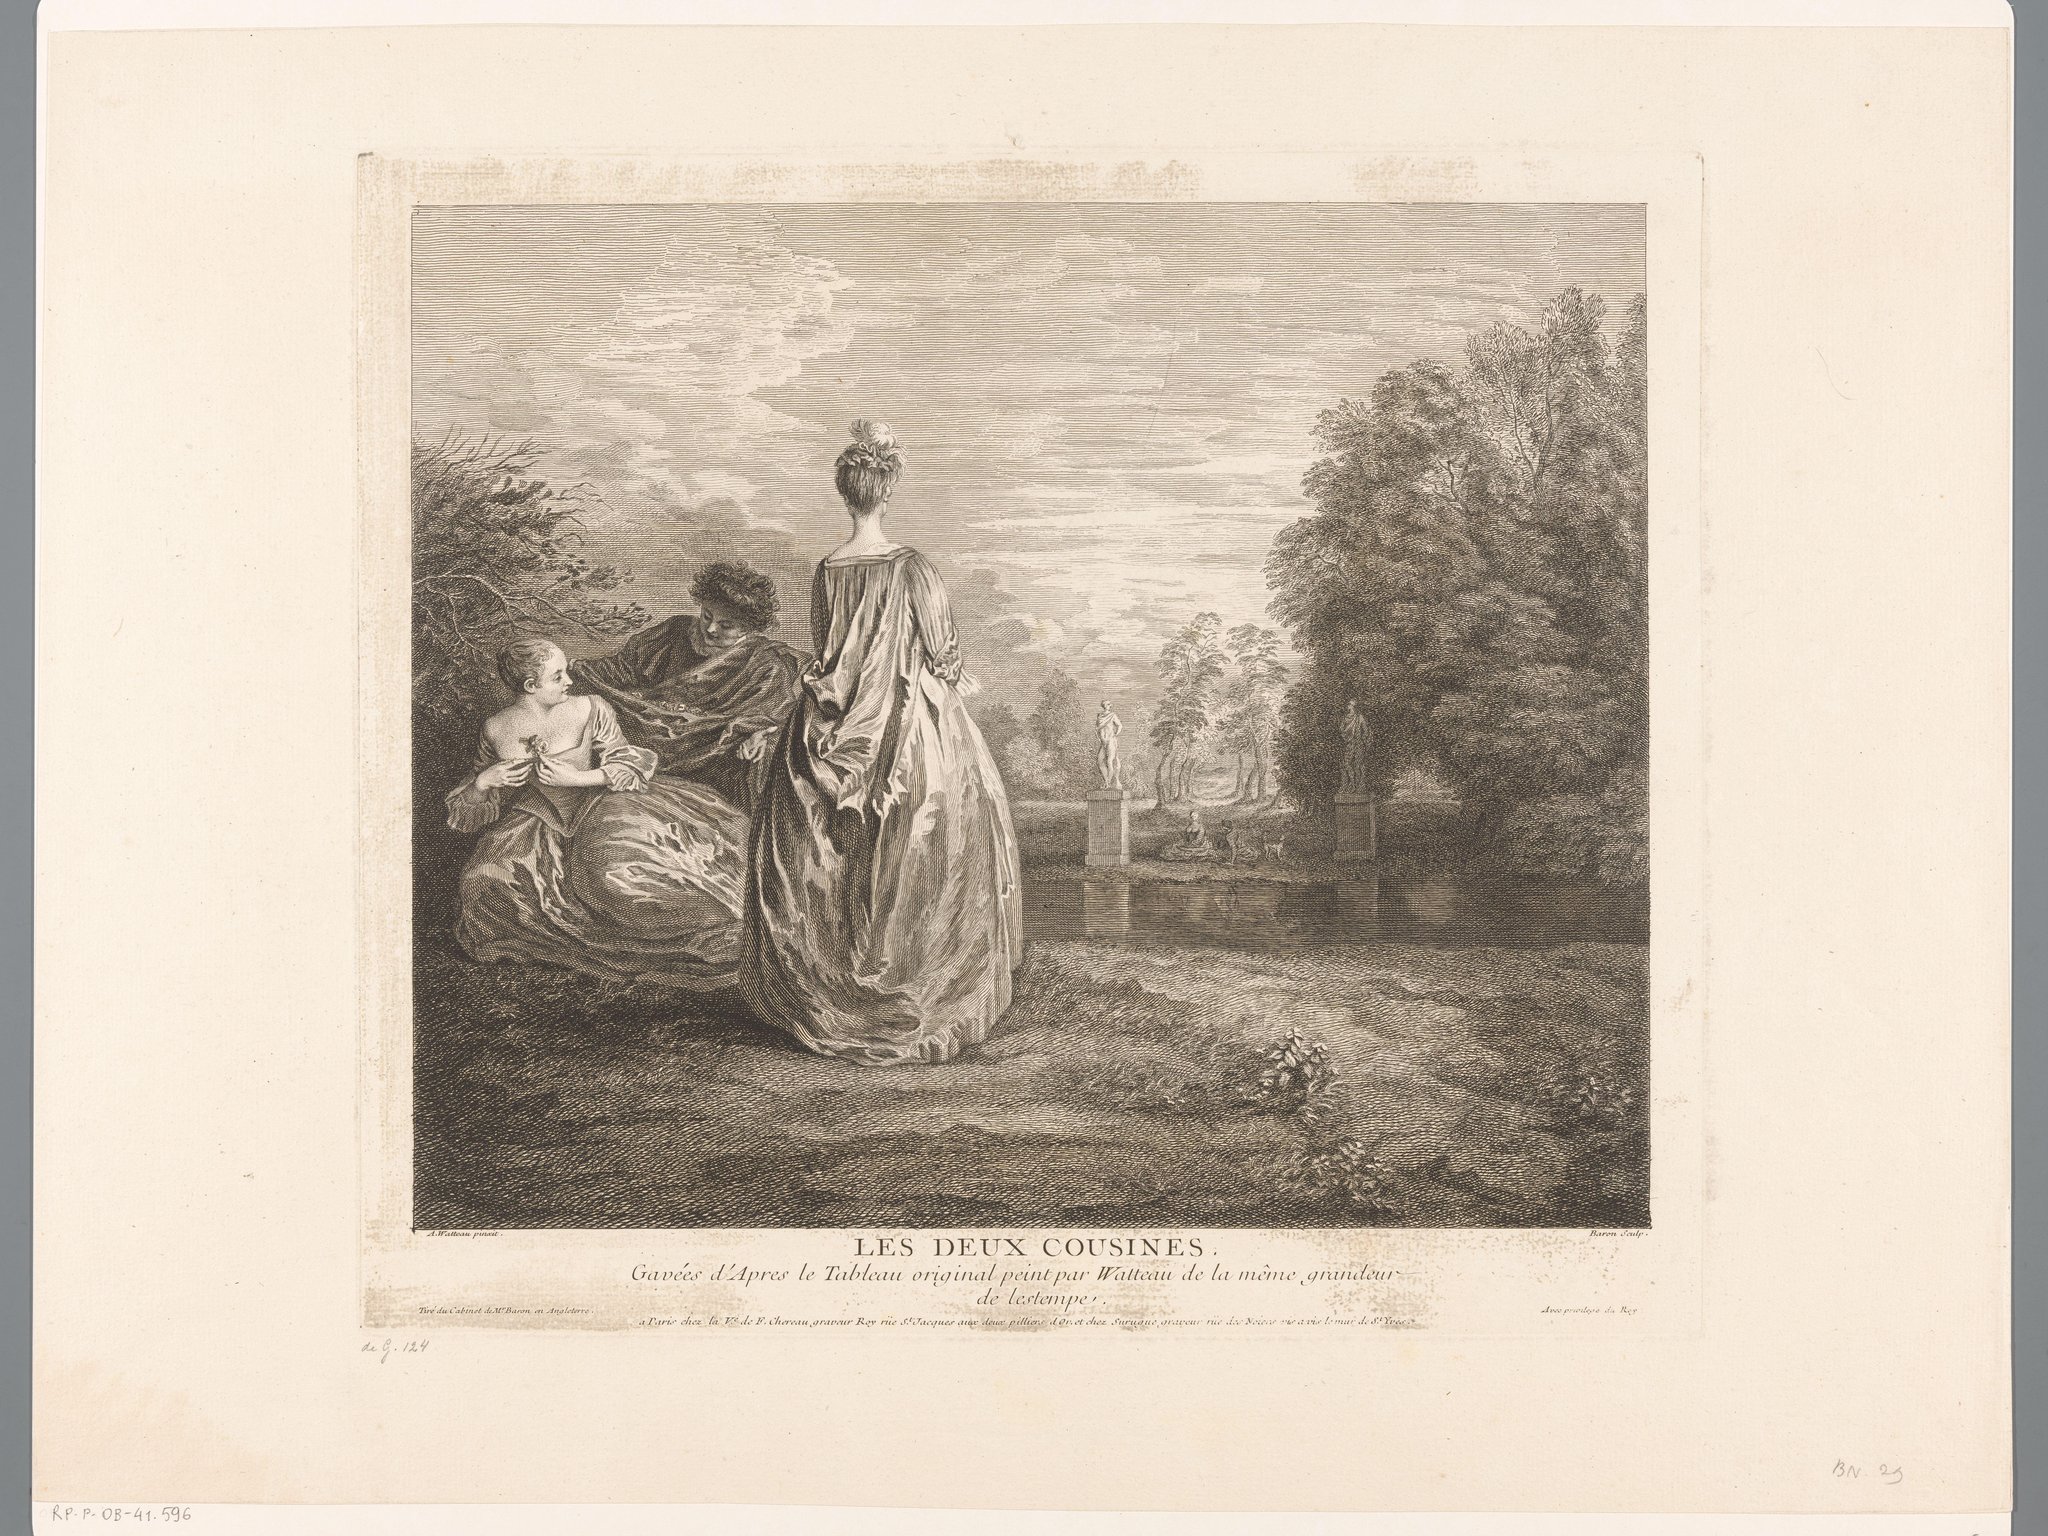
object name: print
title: Landschap met twee vrouwen en een man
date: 1706-1755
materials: paper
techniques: etching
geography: paris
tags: flowers, park, garden pond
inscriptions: collector's mark: Lugt 2228, watermark